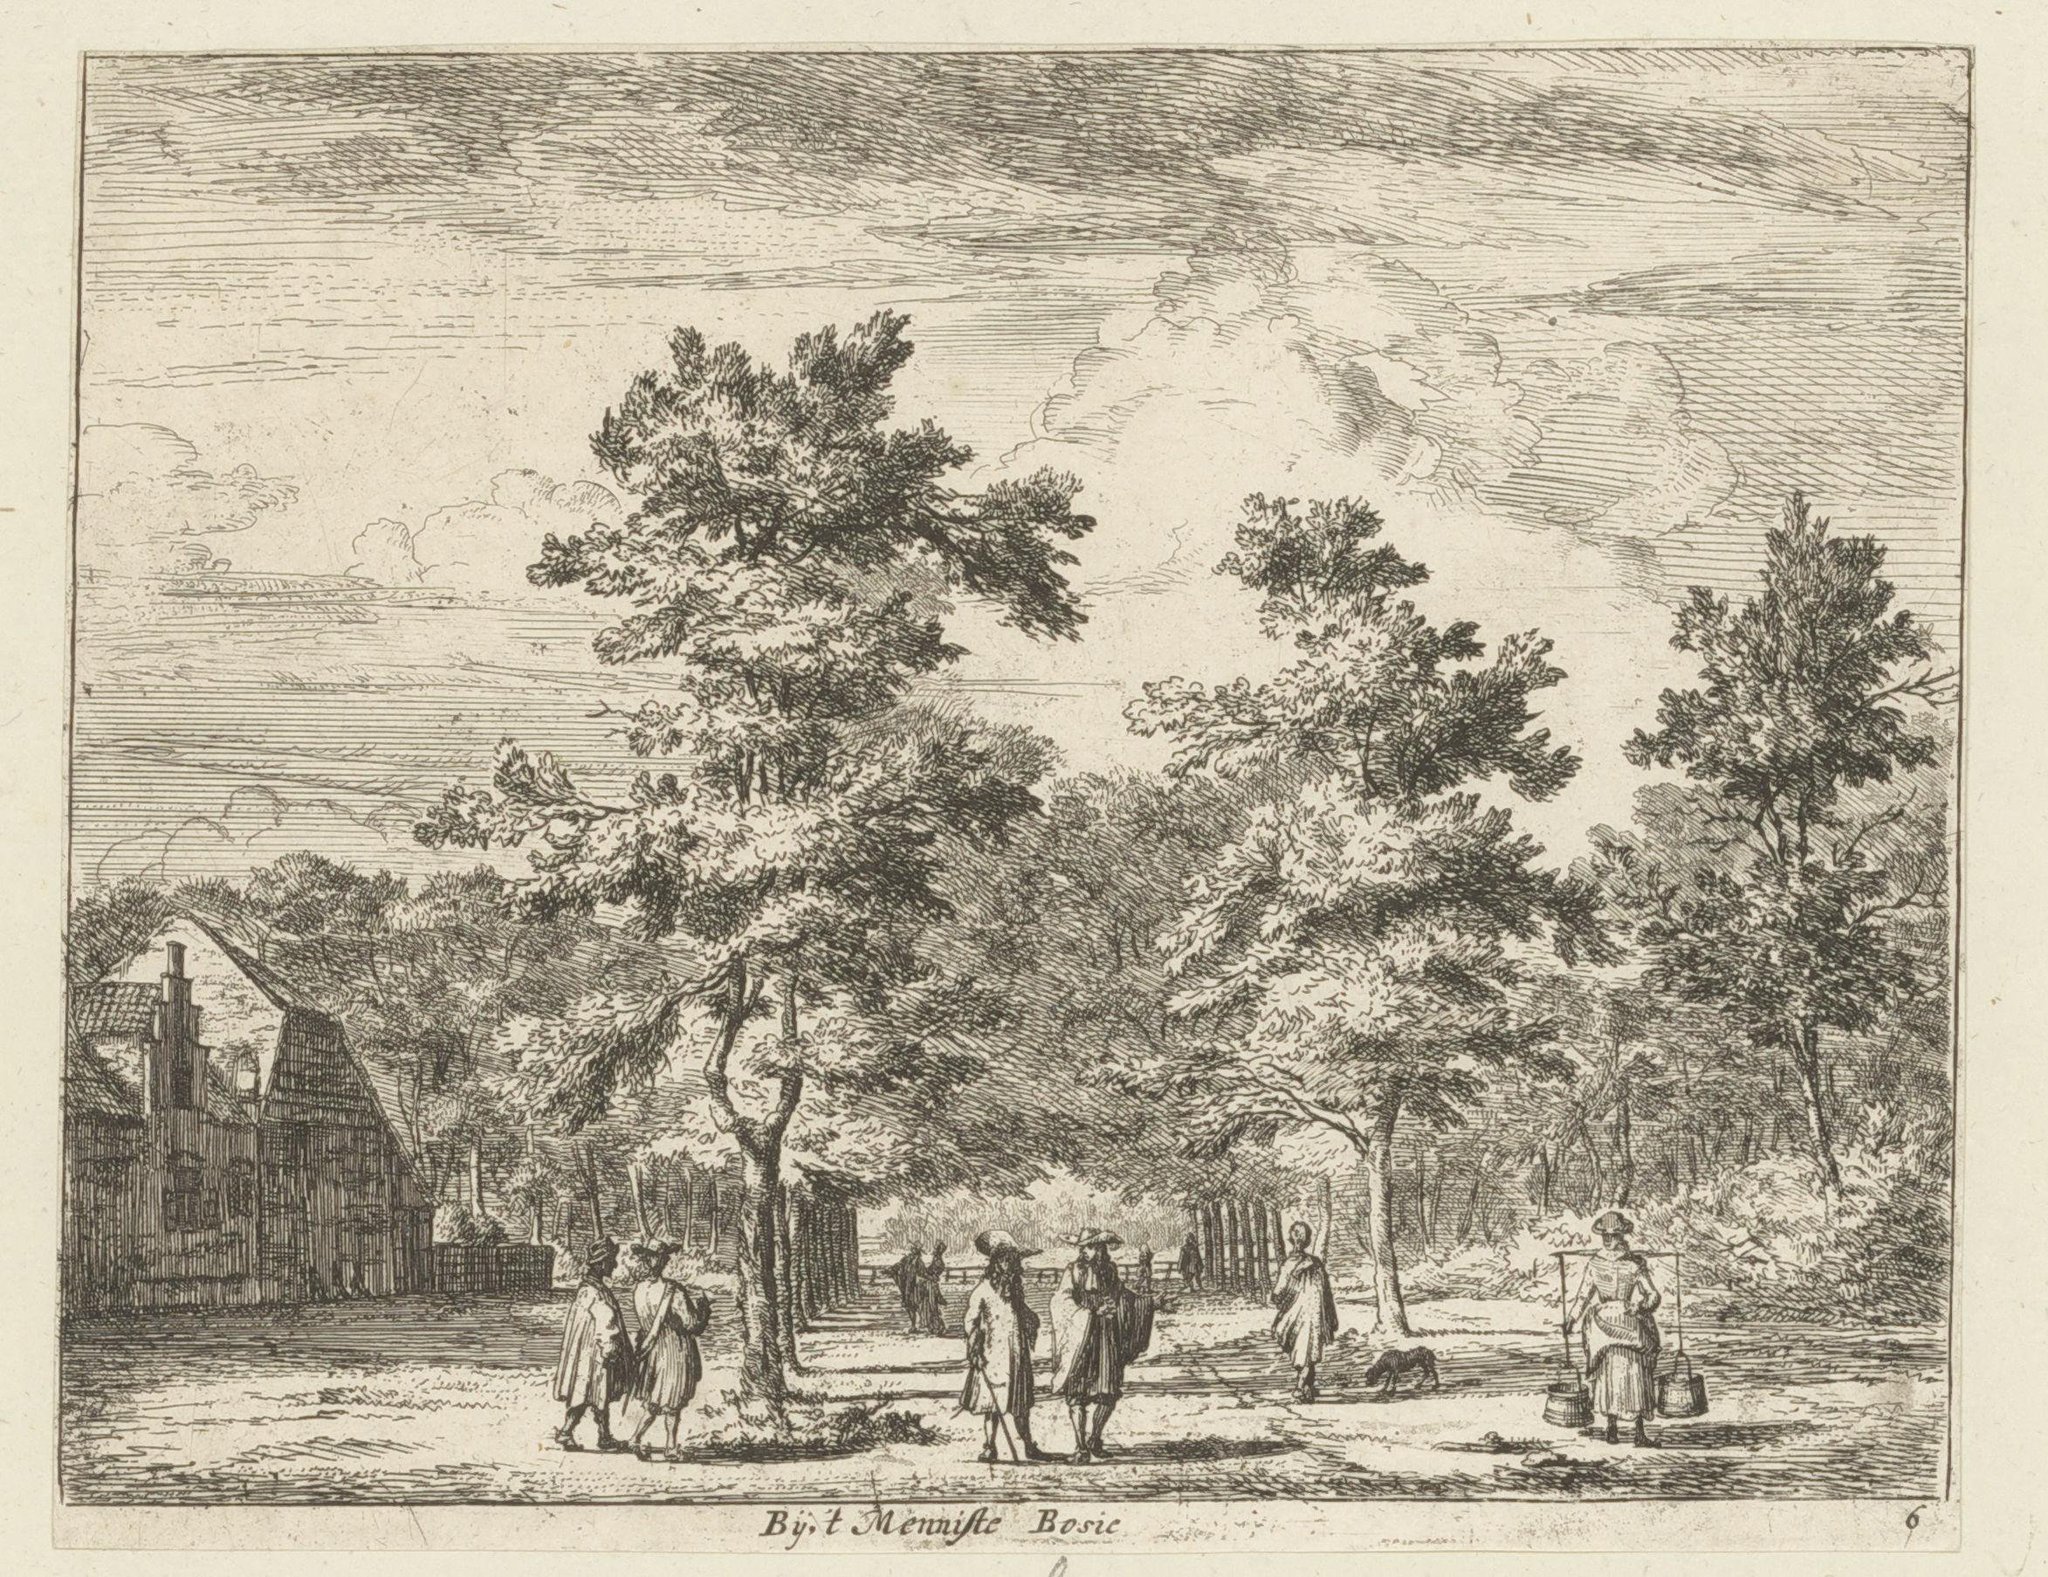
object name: print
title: Wandelende figuren op een laan met bomen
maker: jan vincentsz. van der vinne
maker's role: draughtsman, print maker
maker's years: 1663-1721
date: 1688-1690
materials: paper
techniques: engraving, etching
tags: forest path or lane, carrying something with yoke, landscapes (+ landscape with figures, staffage), milkmaid, haarlem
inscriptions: stamp, collector's mark: Lugt 1641, stamp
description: Wandelende figuren op een laan met bomen. Rechts een melkmeid met een juk. Rechtsonder genummerd: 6. Onderwerpsrubrieken binnen de Atlas Zeden en Gewoonten: Handel, nijverheid en verkeer, Buitenleven.